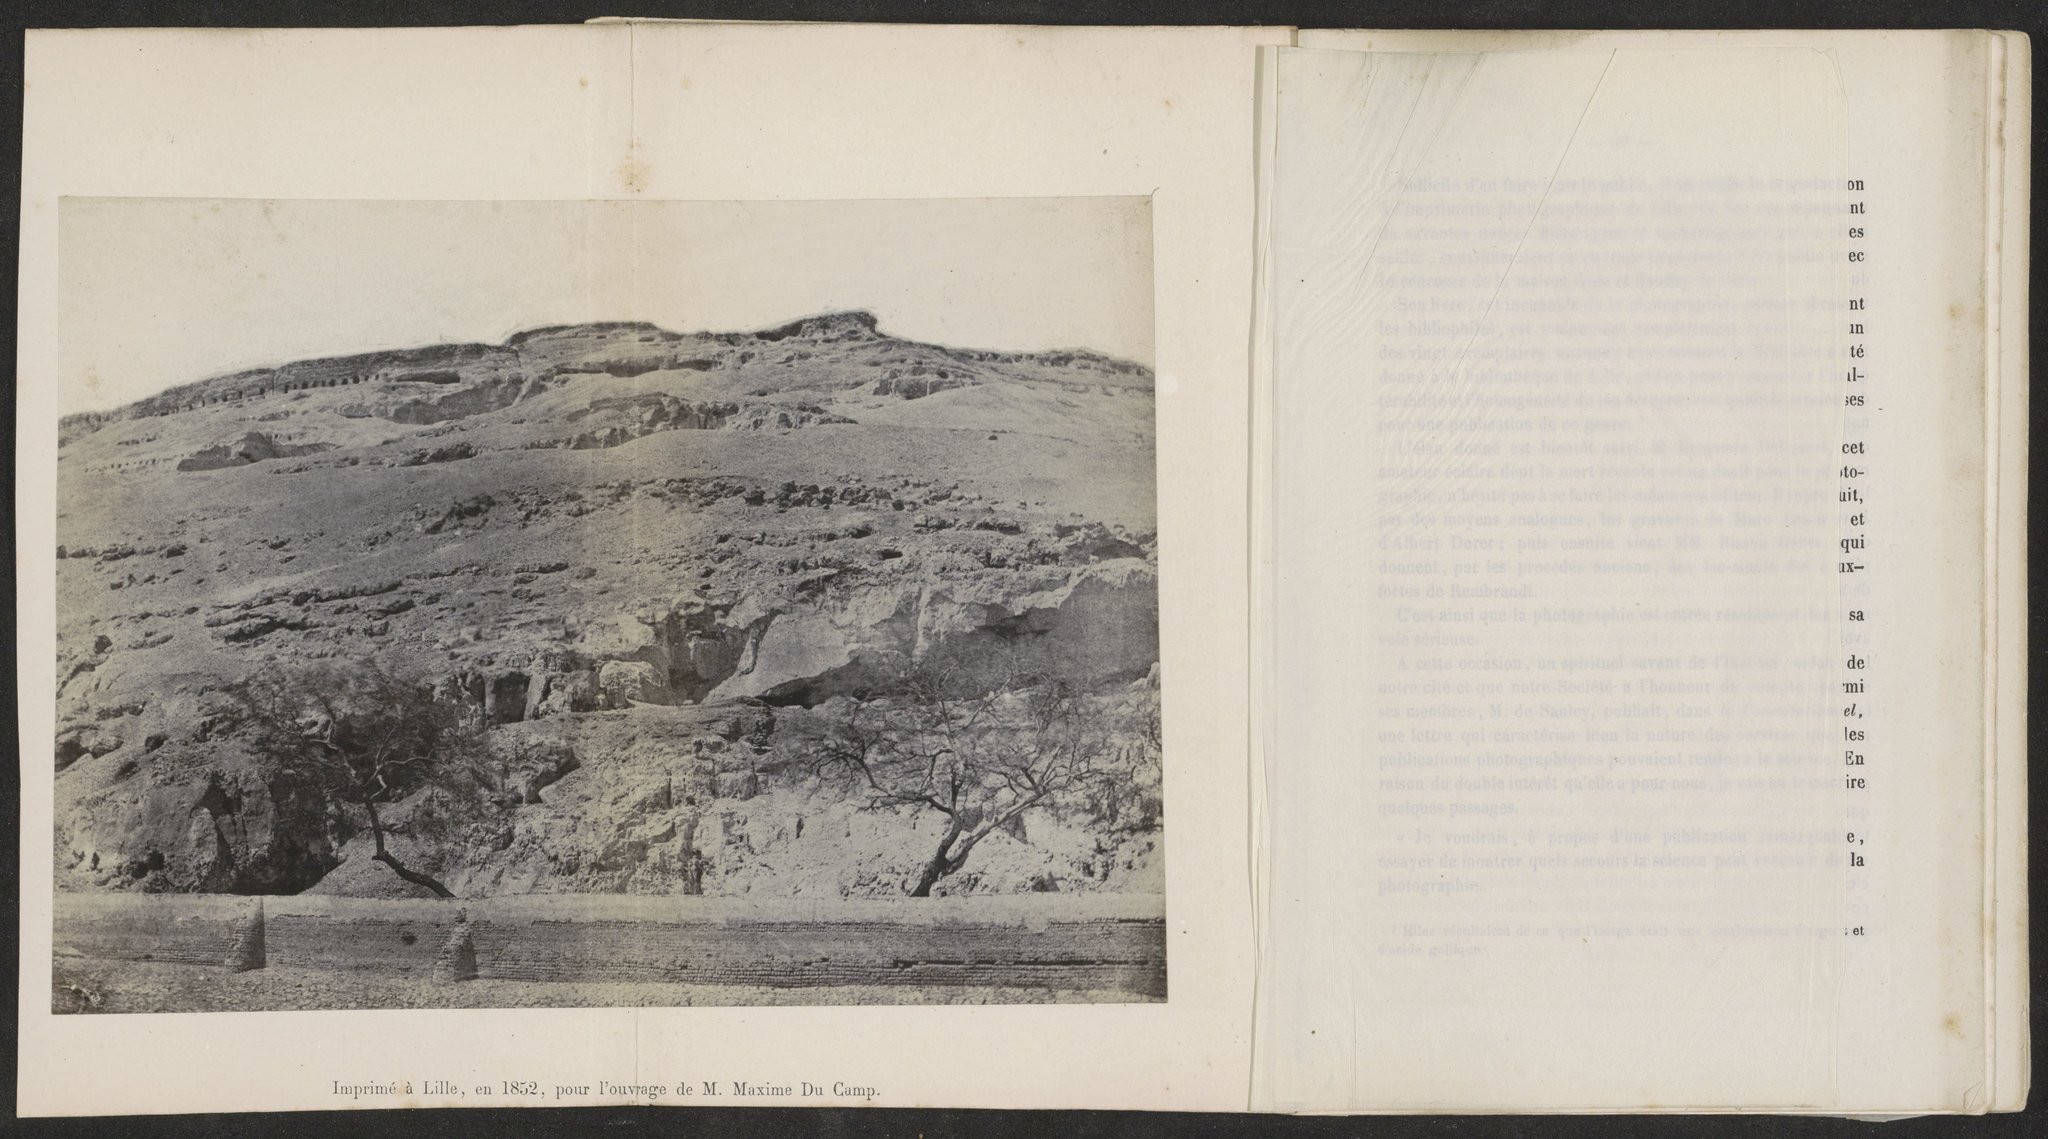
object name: page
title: Gezicht op een heuvel, met op de voorgrond een stenen muur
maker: maxime du camp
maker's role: fotograaf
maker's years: 1822-1894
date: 1850-1852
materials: photographic support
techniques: salted paper print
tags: low hill country, fence, wall, paling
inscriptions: inscription: ‘Imprimé à Lille, en 1852, pour l'ouvrage de M. Maxime Du Camp.’